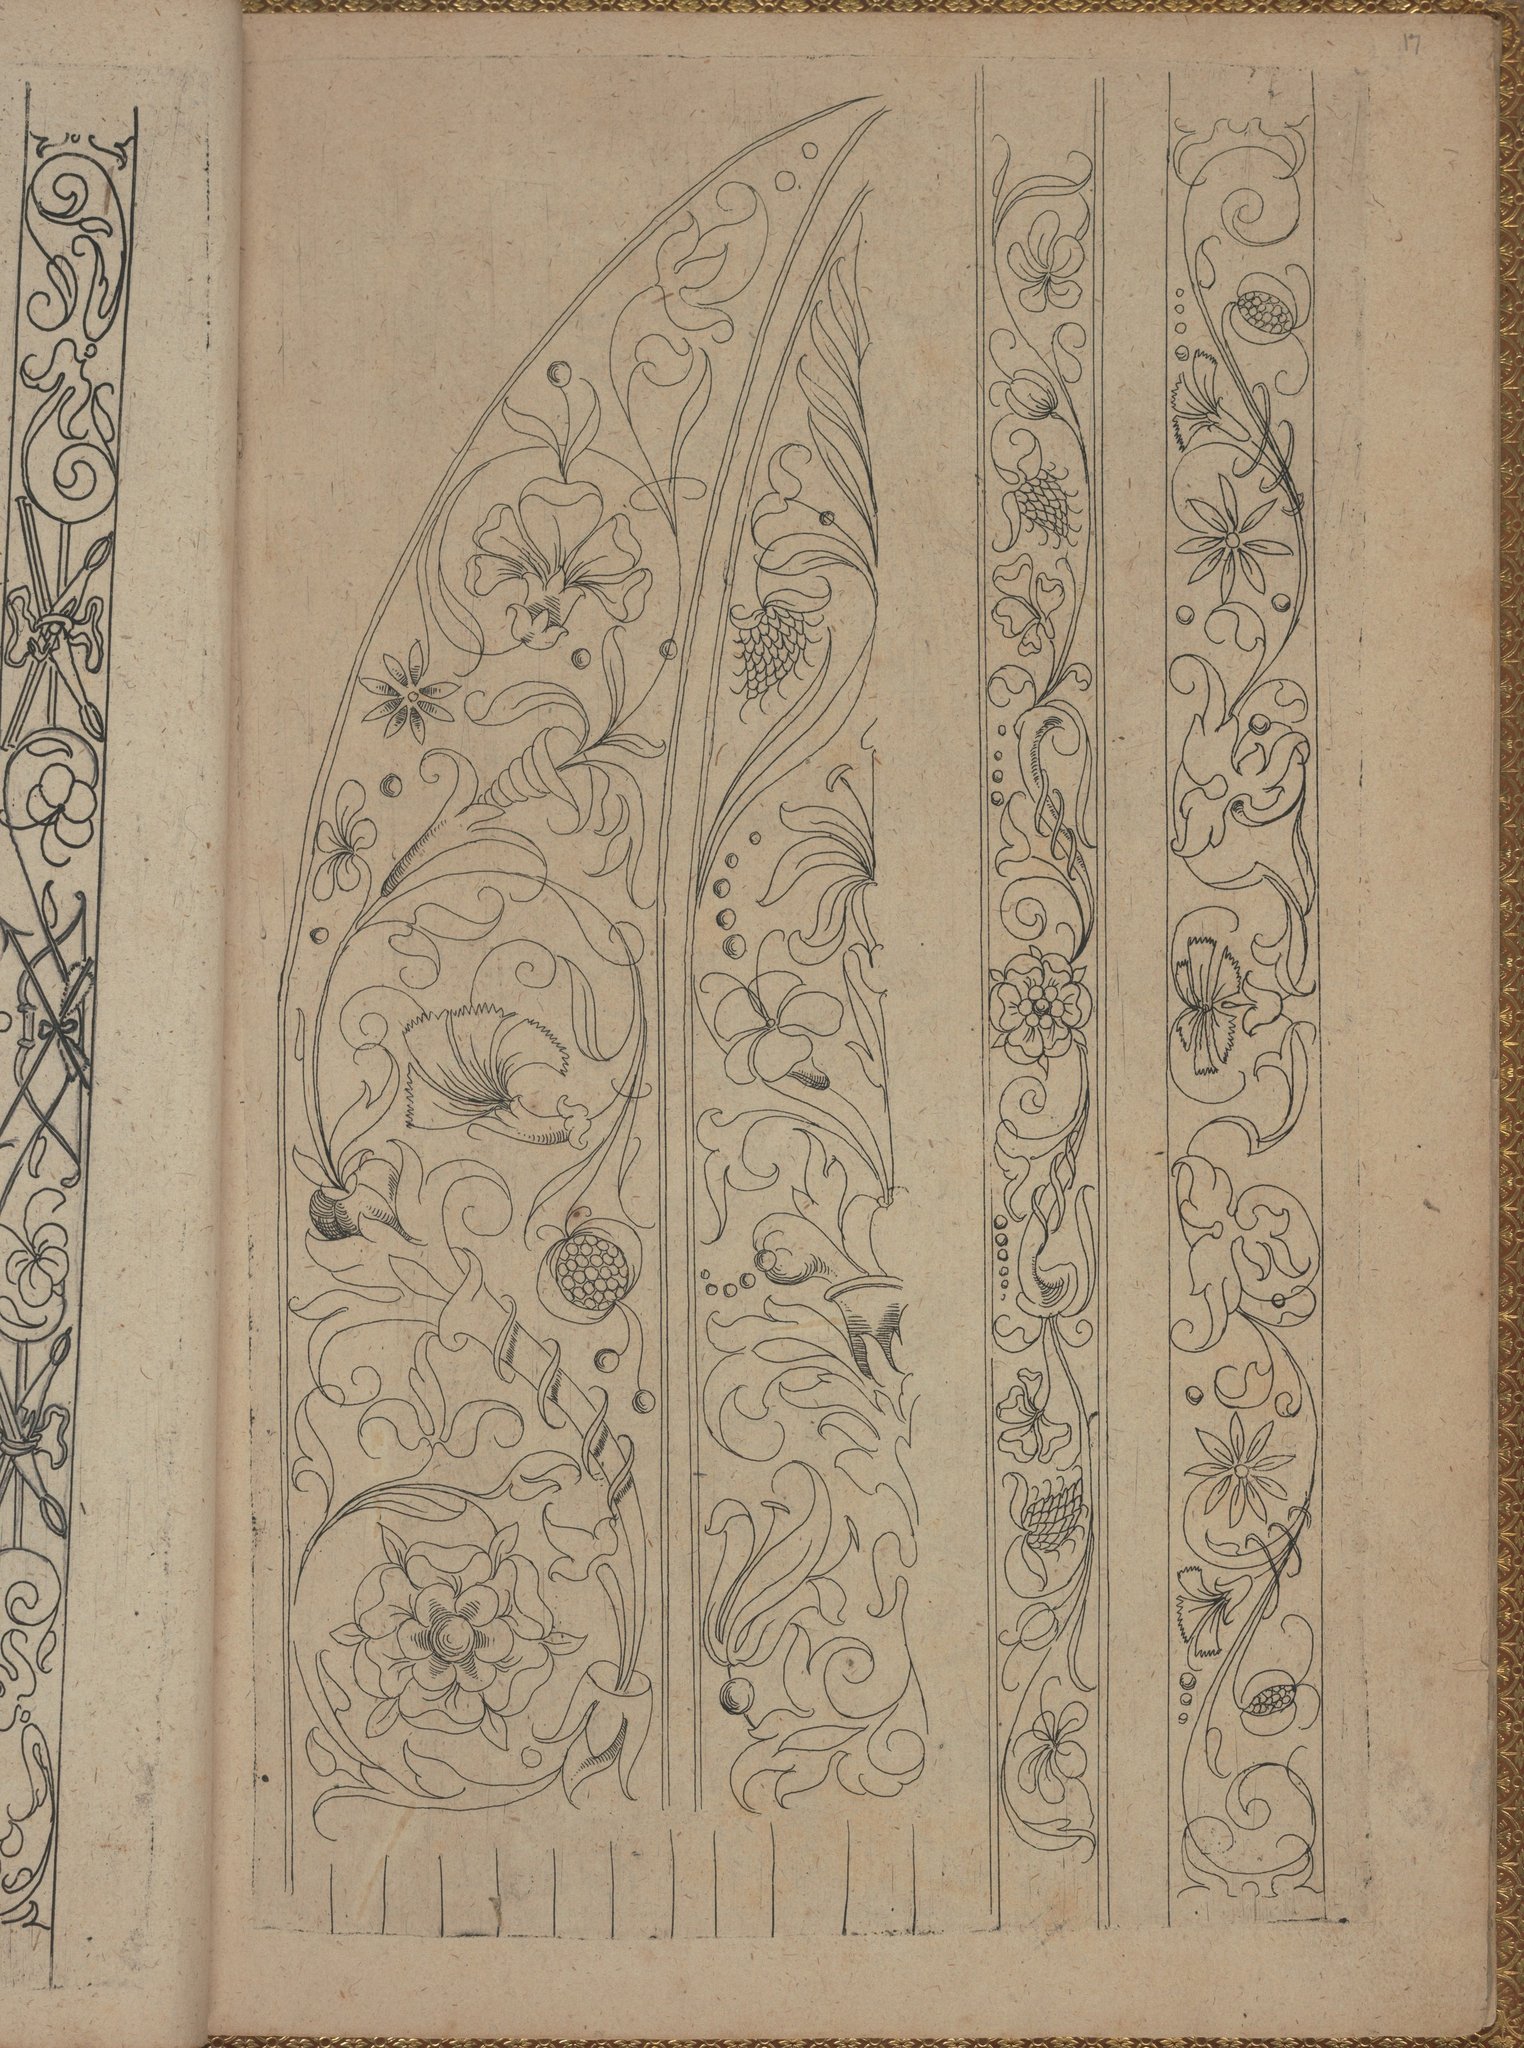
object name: book print ornament architecture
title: New Modelbüch (Page 17v)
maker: andreas bretschneider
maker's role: designer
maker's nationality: german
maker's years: 1573-1645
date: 1615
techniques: etching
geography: germany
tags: flowers